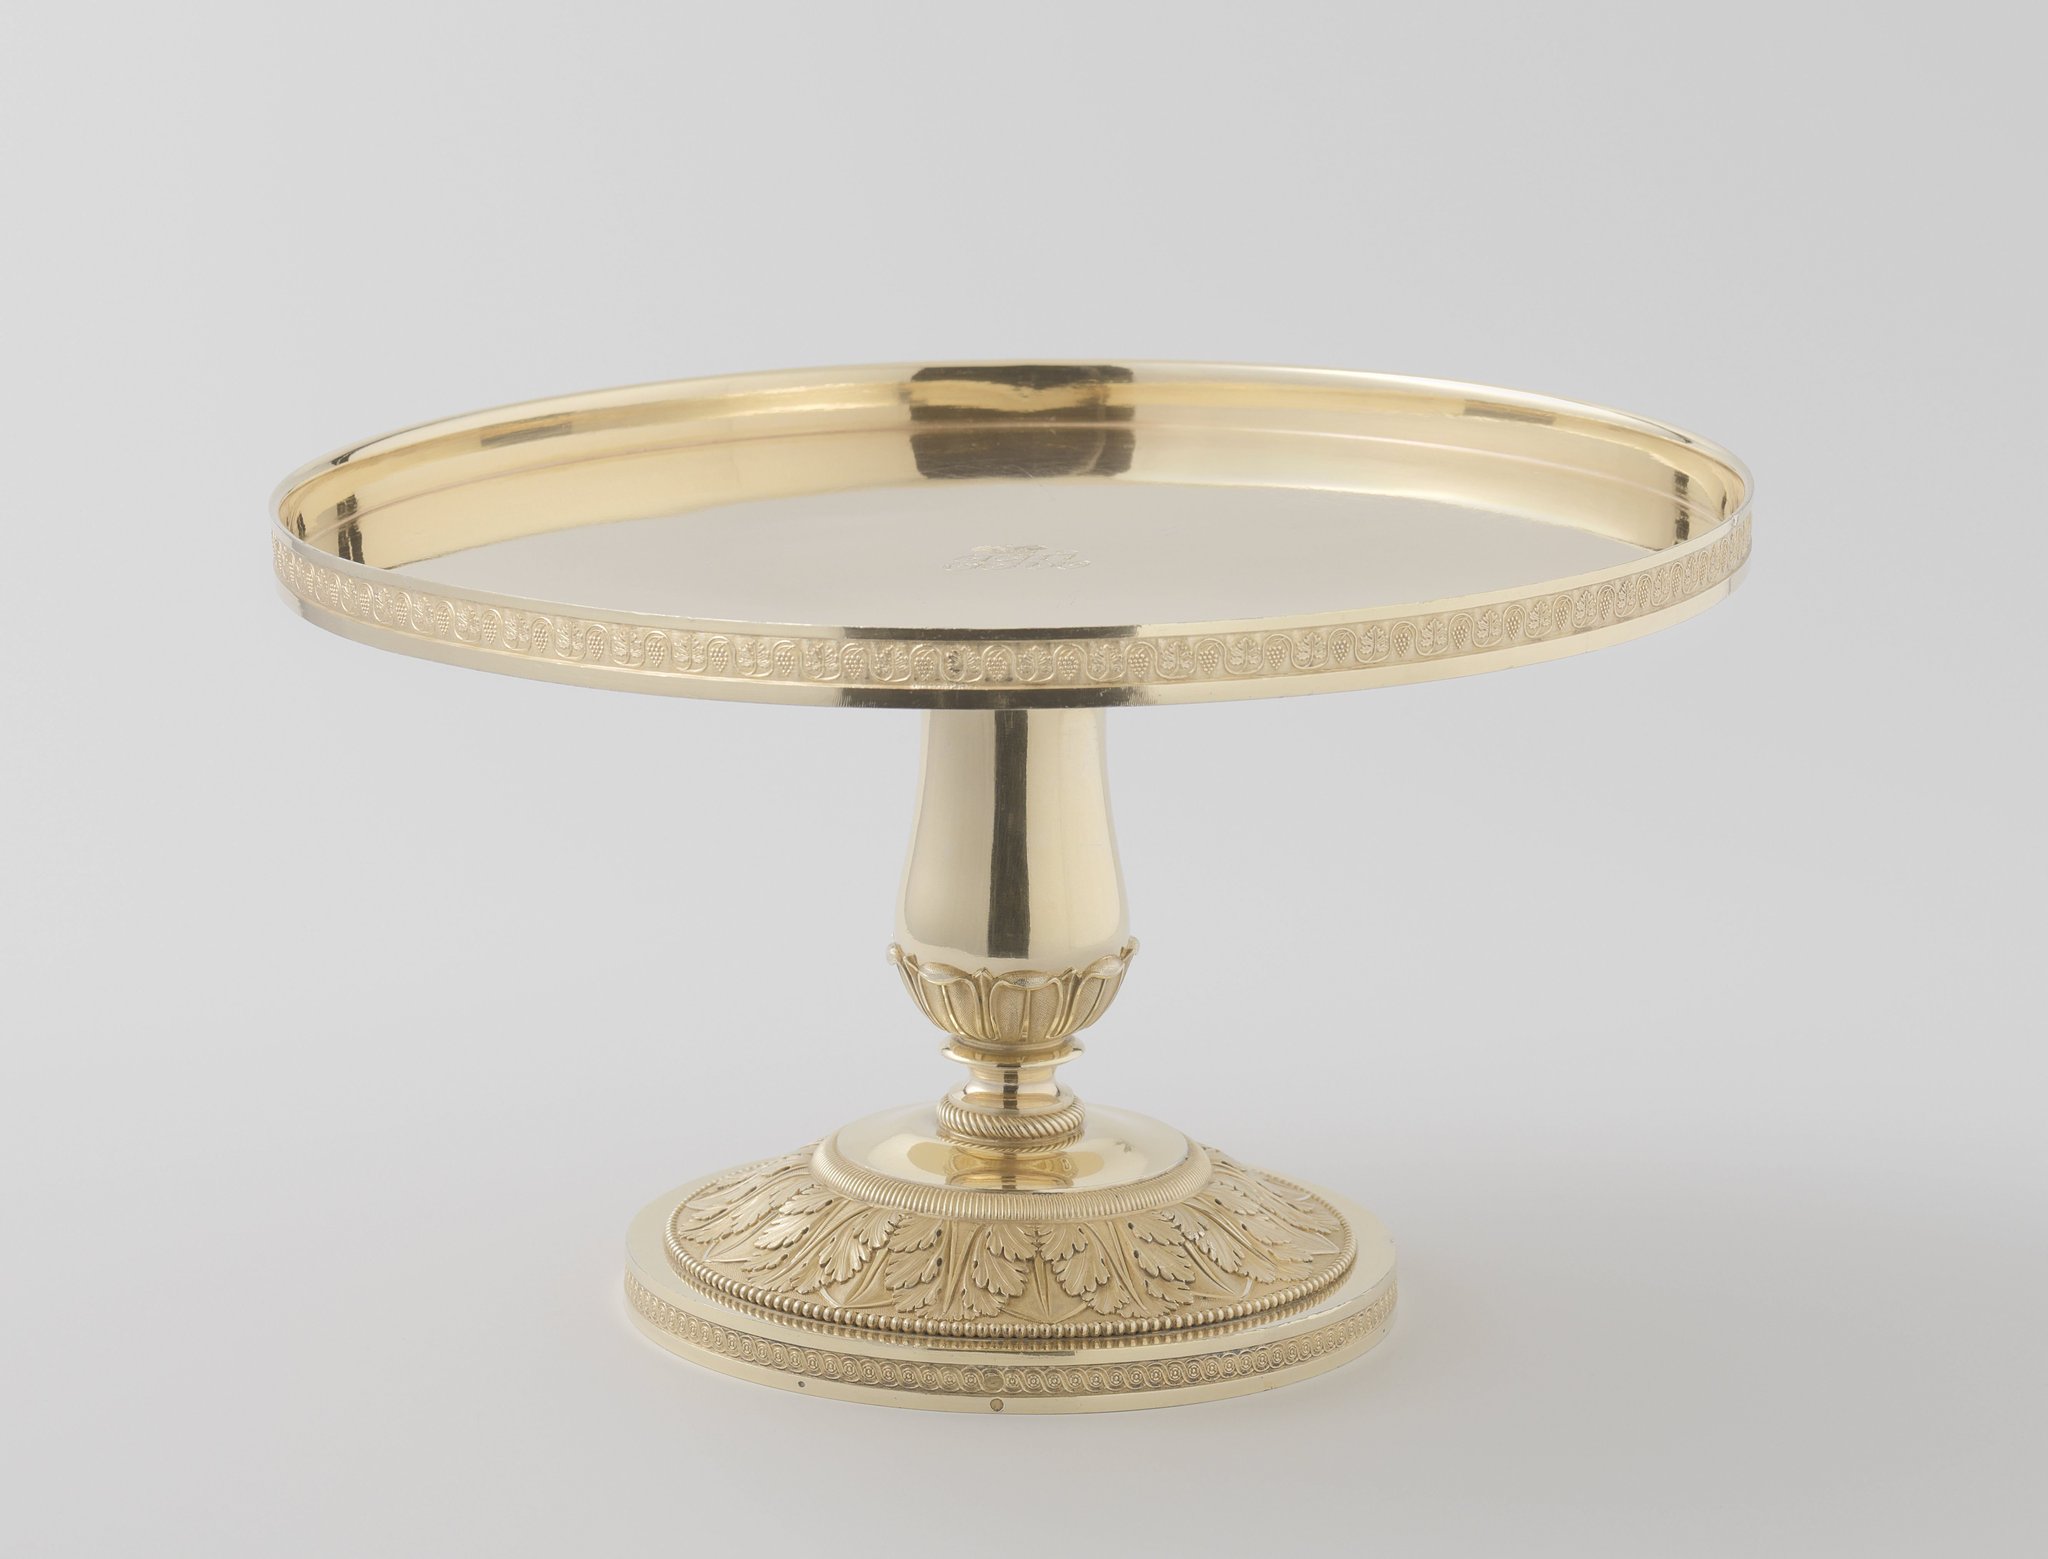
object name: cake plate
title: Tea tray, cake stands, jam dish, sugar bowls, coffee pot and milk jug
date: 1817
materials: wood, silver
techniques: gilding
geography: paris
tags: acanthus ~ ornament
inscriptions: monogram, inscription: ‘Biennais Orfevre Rue St Honoré No 283 à Paris’, mark, maker's mark, duty mark, alloy mark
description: This is not just any service. These objects belong to a huge coffee and tea service that originally comprised more than a thousand pieces. The Russian tsar Nicholas I bought it from the French silversmith Biennais in 1817. The pieces are double gilded, so they look like they are made of solid gold. The geometric shapes and type of rims are typical of the early Empire style.